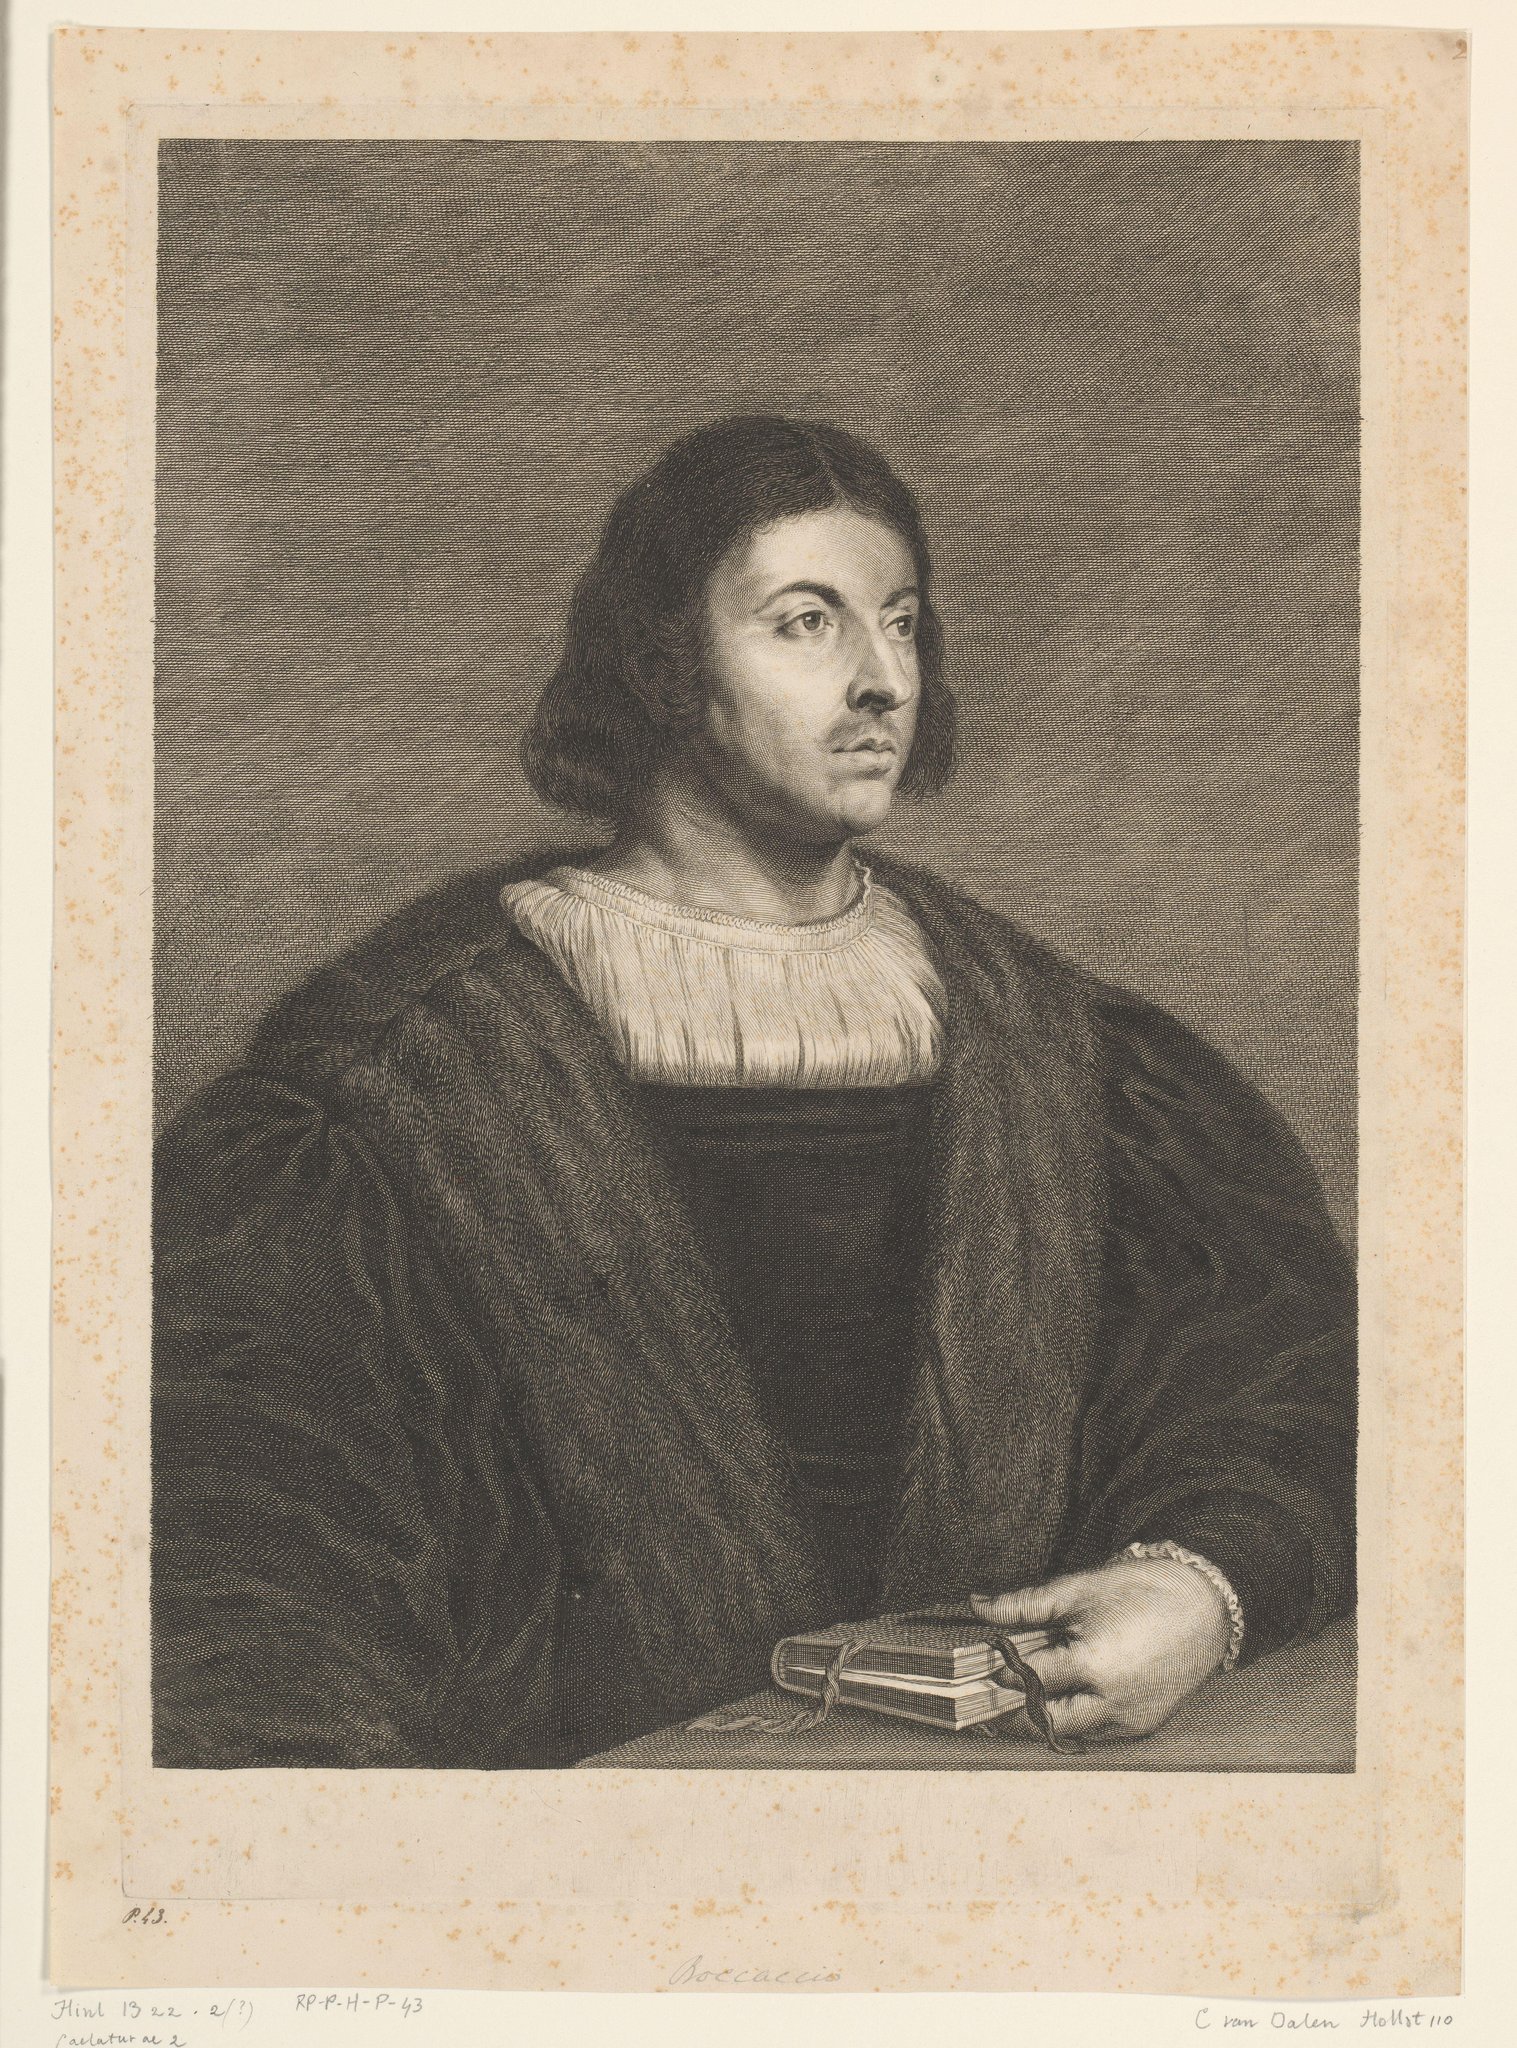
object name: print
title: Caelaturae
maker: cornelis van dalen (ii)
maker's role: draughtsman, print maker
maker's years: 1638-1664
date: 1648-1664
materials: paper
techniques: engraving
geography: amsterdam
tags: giovanni boccaccio, bard, lyric poet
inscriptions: collector's mark: Lugt 11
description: Deze prent maakte ten minste tot 1979 deel uit van een prentalbum met de titel: 't Cabinet der Italiaense schilderije antique statue en borstbeelde van de heer Renst 145 stucks. Simon Schijnvoet heeft in 1709 aan dit album het Schijnvoet-nummer 22, liber nummer 20 toegekend. Prent uit serie Caelaturae met vierendertig reprodukties naar Italiaanse en Nederlandse schilders, vervaardigd door de allerbeste graveurs in opdracht van de verzamelaar Gerard Reynst.